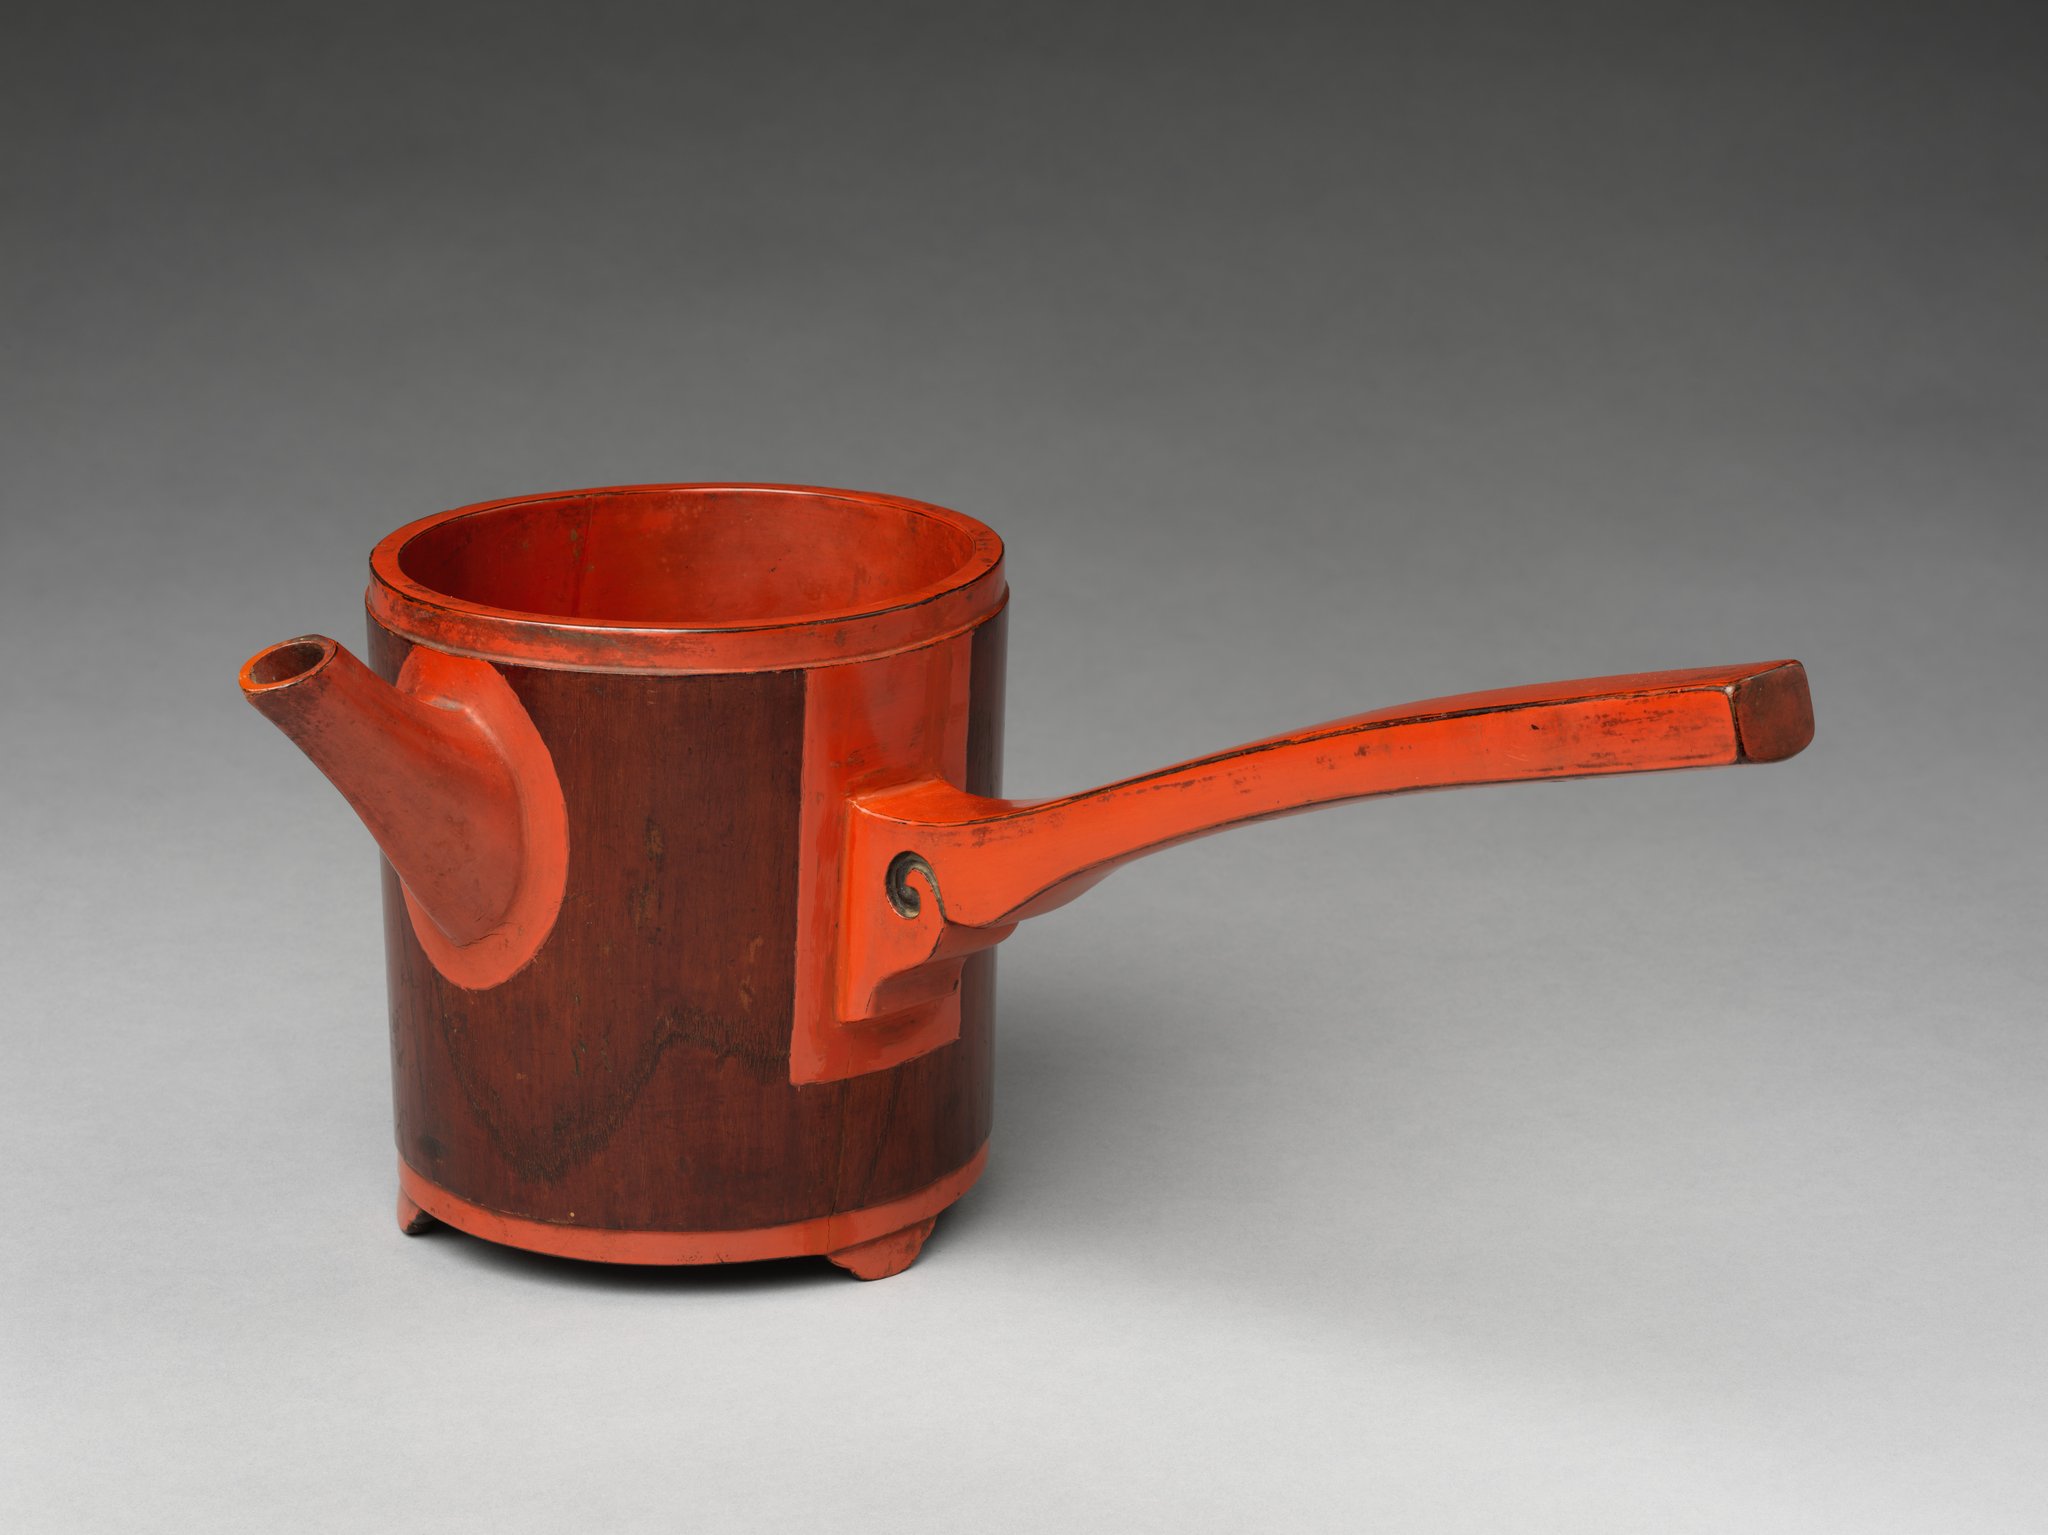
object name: pouring vessel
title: Pouring vessel with handle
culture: japanese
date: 1392-1568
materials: lacquer, wood